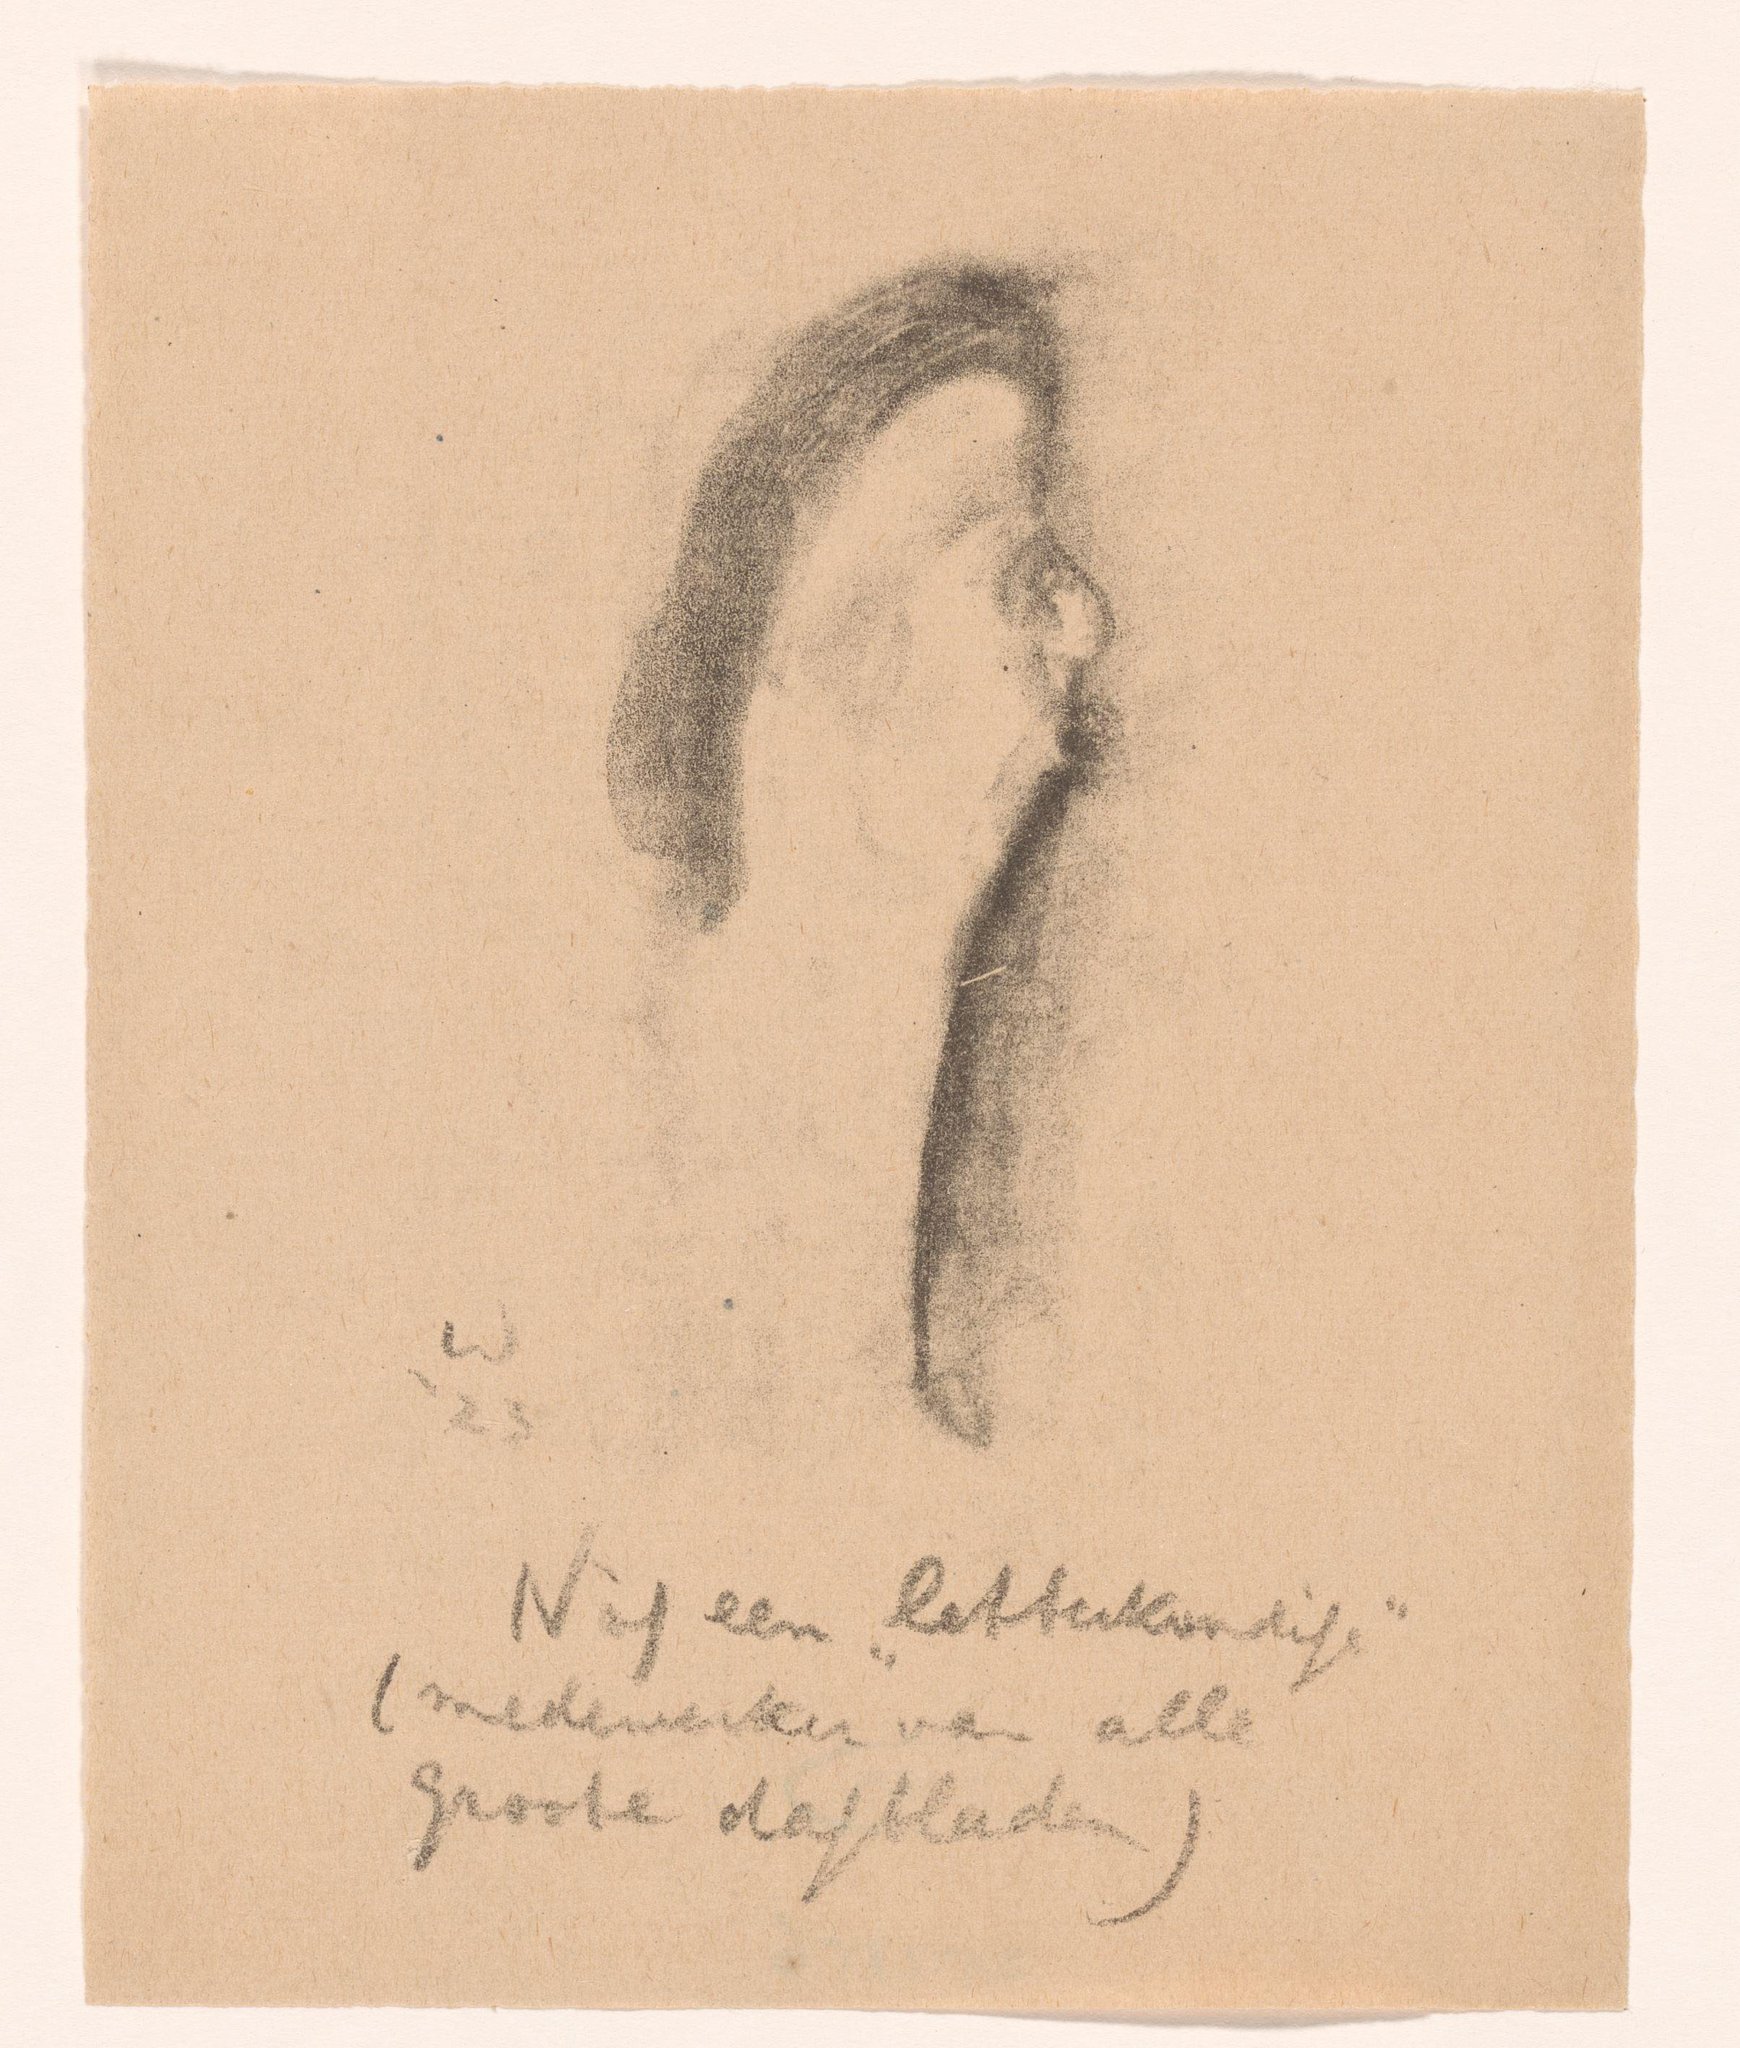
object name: print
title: Karikatuur van een letterkundige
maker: erich wichmann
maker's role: print maker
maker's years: 1890-1929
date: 1923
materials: paper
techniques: lithograph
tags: caricatures (human types), writer, poet, author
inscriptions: collector's mark: Lugt 2228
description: Geabstraheerde figuur. Onderaan de tekst: 'Nòg een "letterkundige" (medewerker van alle groote dagbladen)'.